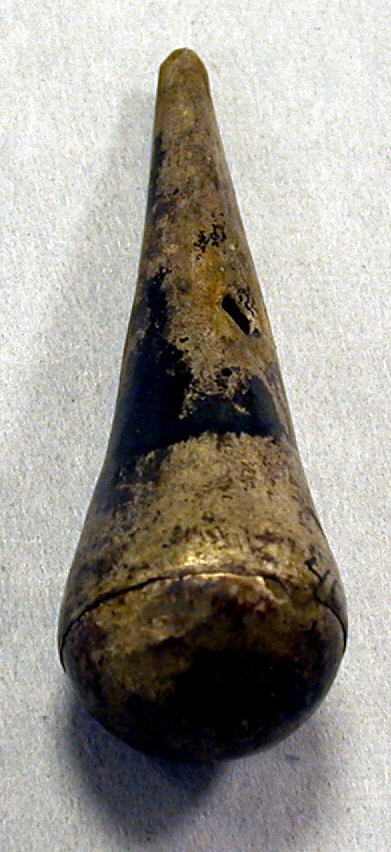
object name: ornament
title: Hammered Silver Cone Ornament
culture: peruvian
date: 701-1566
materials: gilt, silver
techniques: hammering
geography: peru